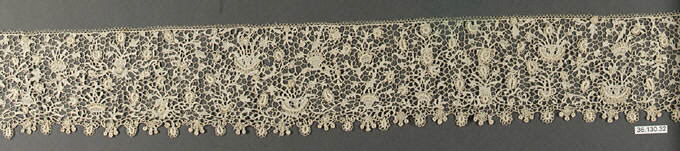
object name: border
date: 1701-1800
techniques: lace